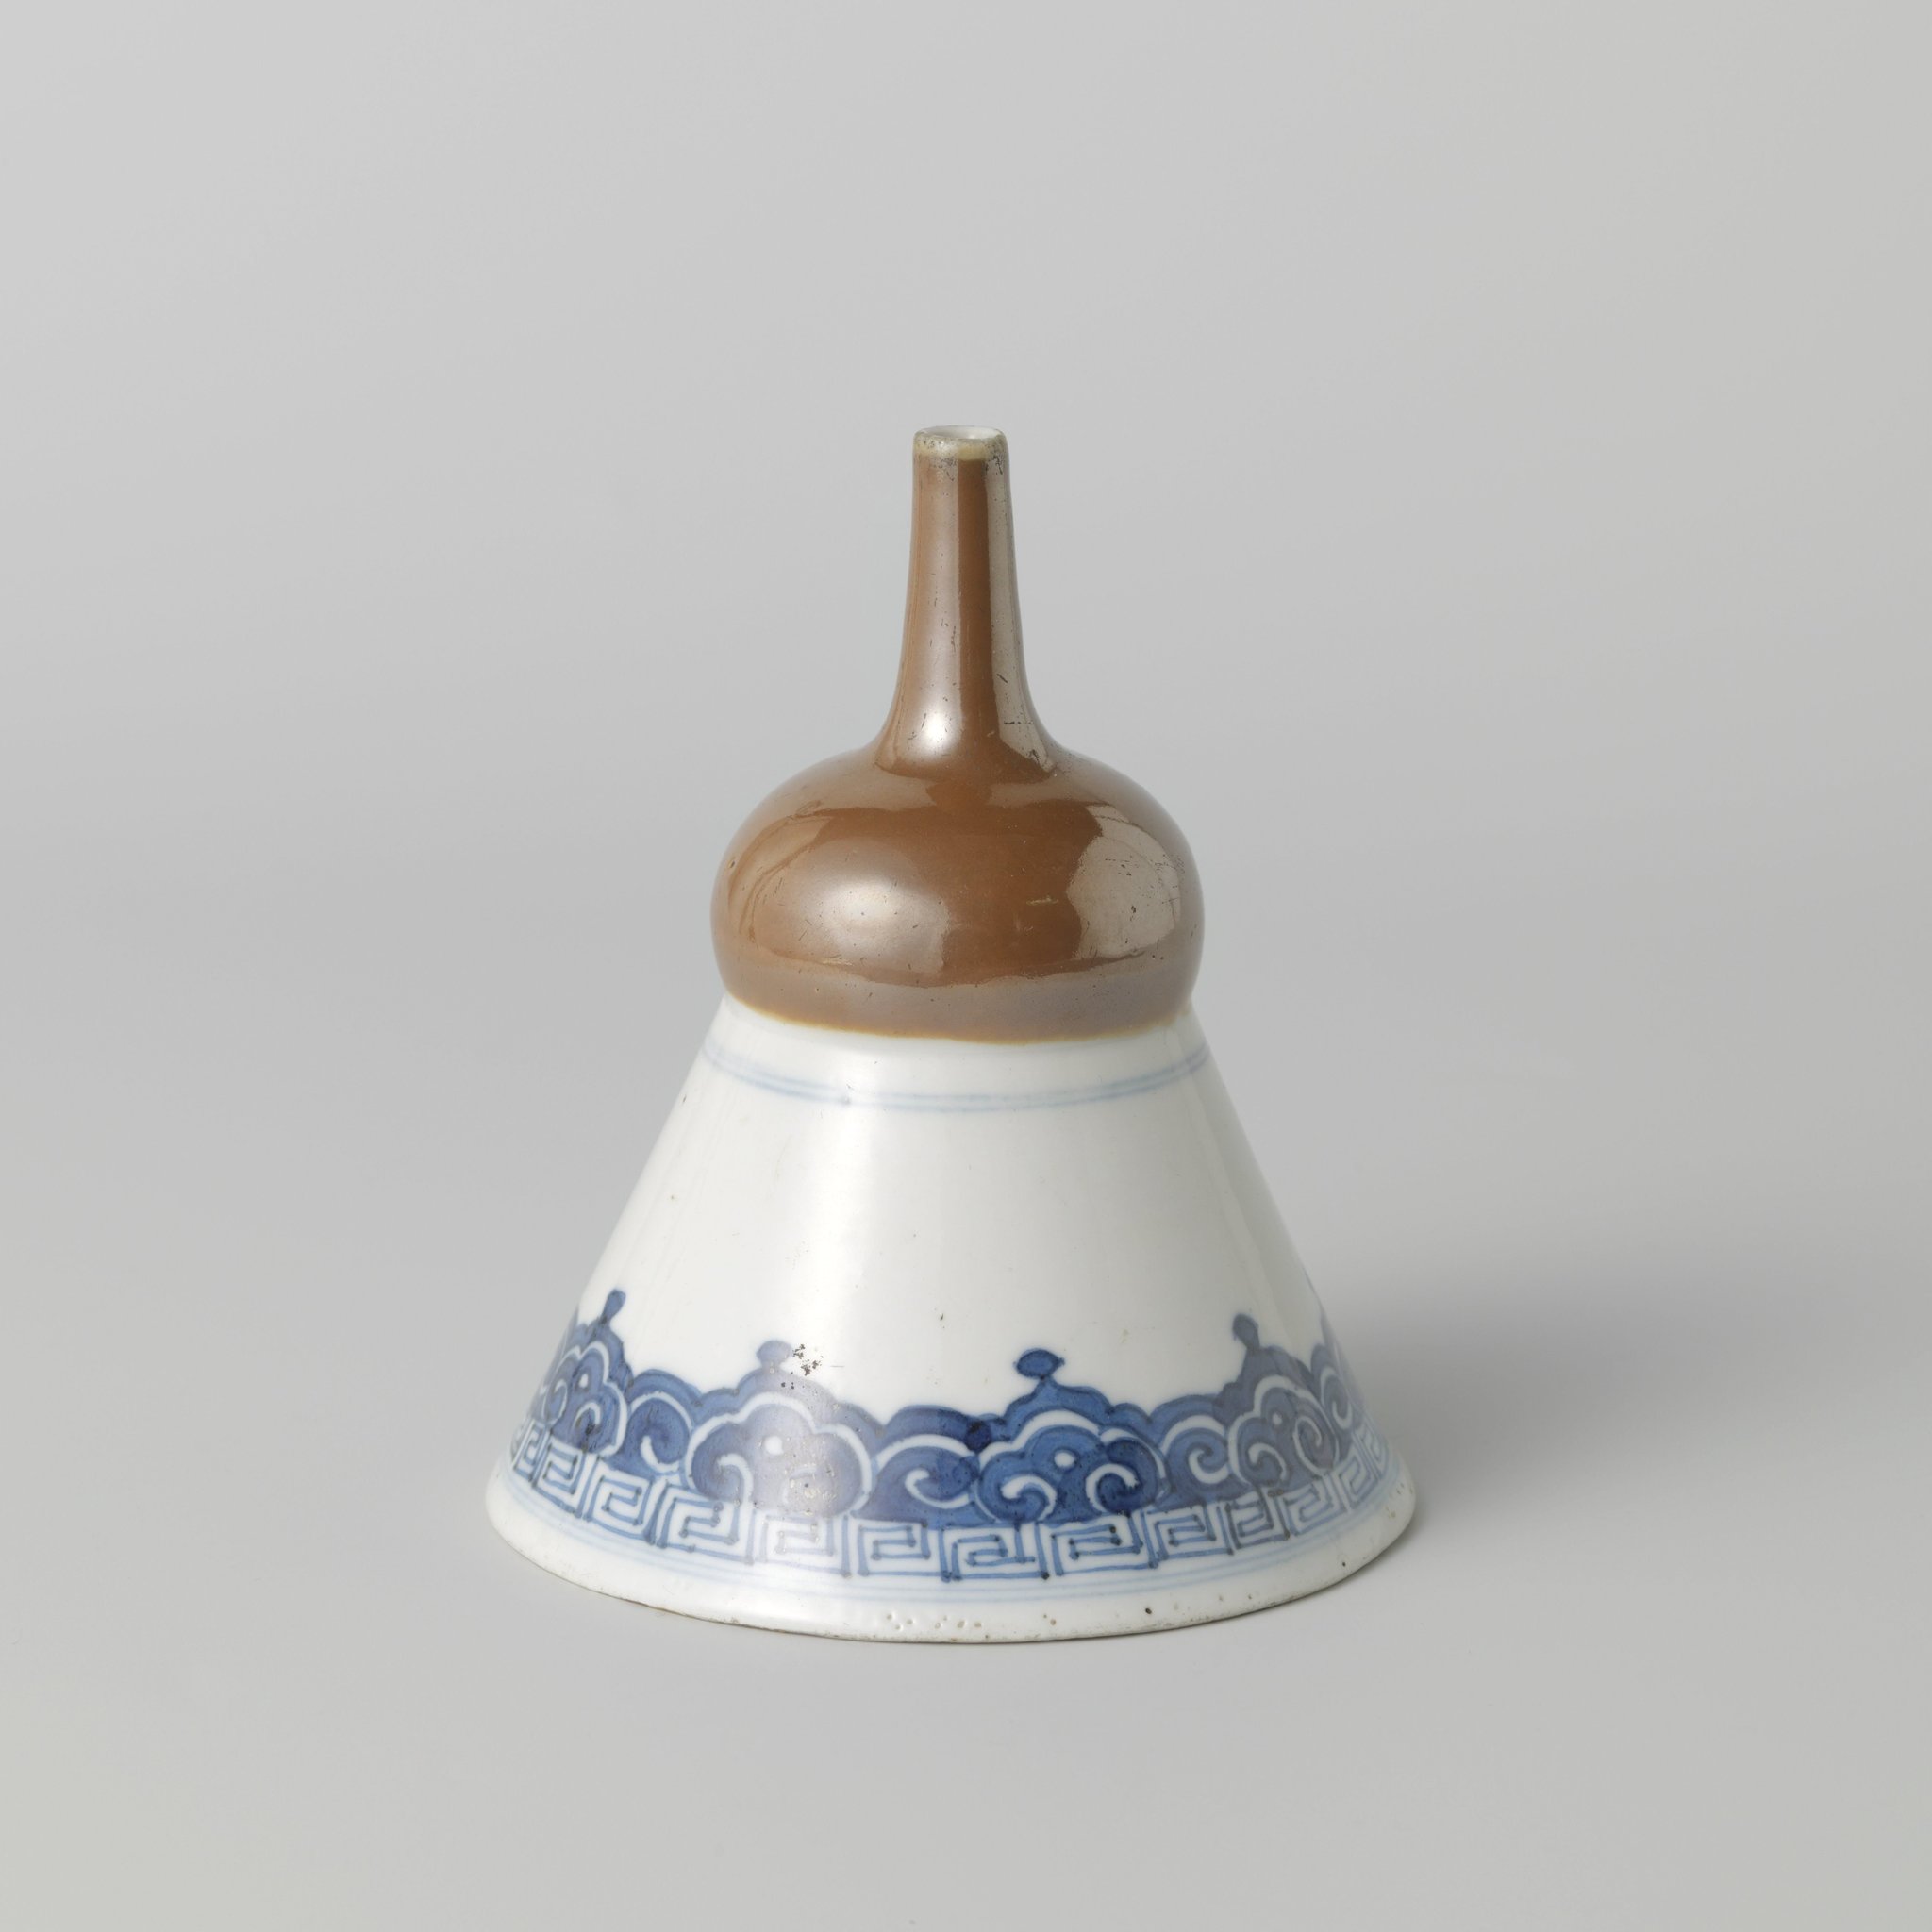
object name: funnel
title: Funnel with a brown glaze and ruyi border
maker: Anonymous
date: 1700-1724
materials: cobalt, glaze, paint, porcelain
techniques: firing, turning, vitrification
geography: china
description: Trechter van porselein met rechtwandige, uitlopende cup, bol tussen cup en steel, beschilderd in onderglazuur blauw en bruin. De cup met een band ruyi-motieven met meander-patroon; de steel met bruin glazuur. Monochroom bruin met blauw-wit.